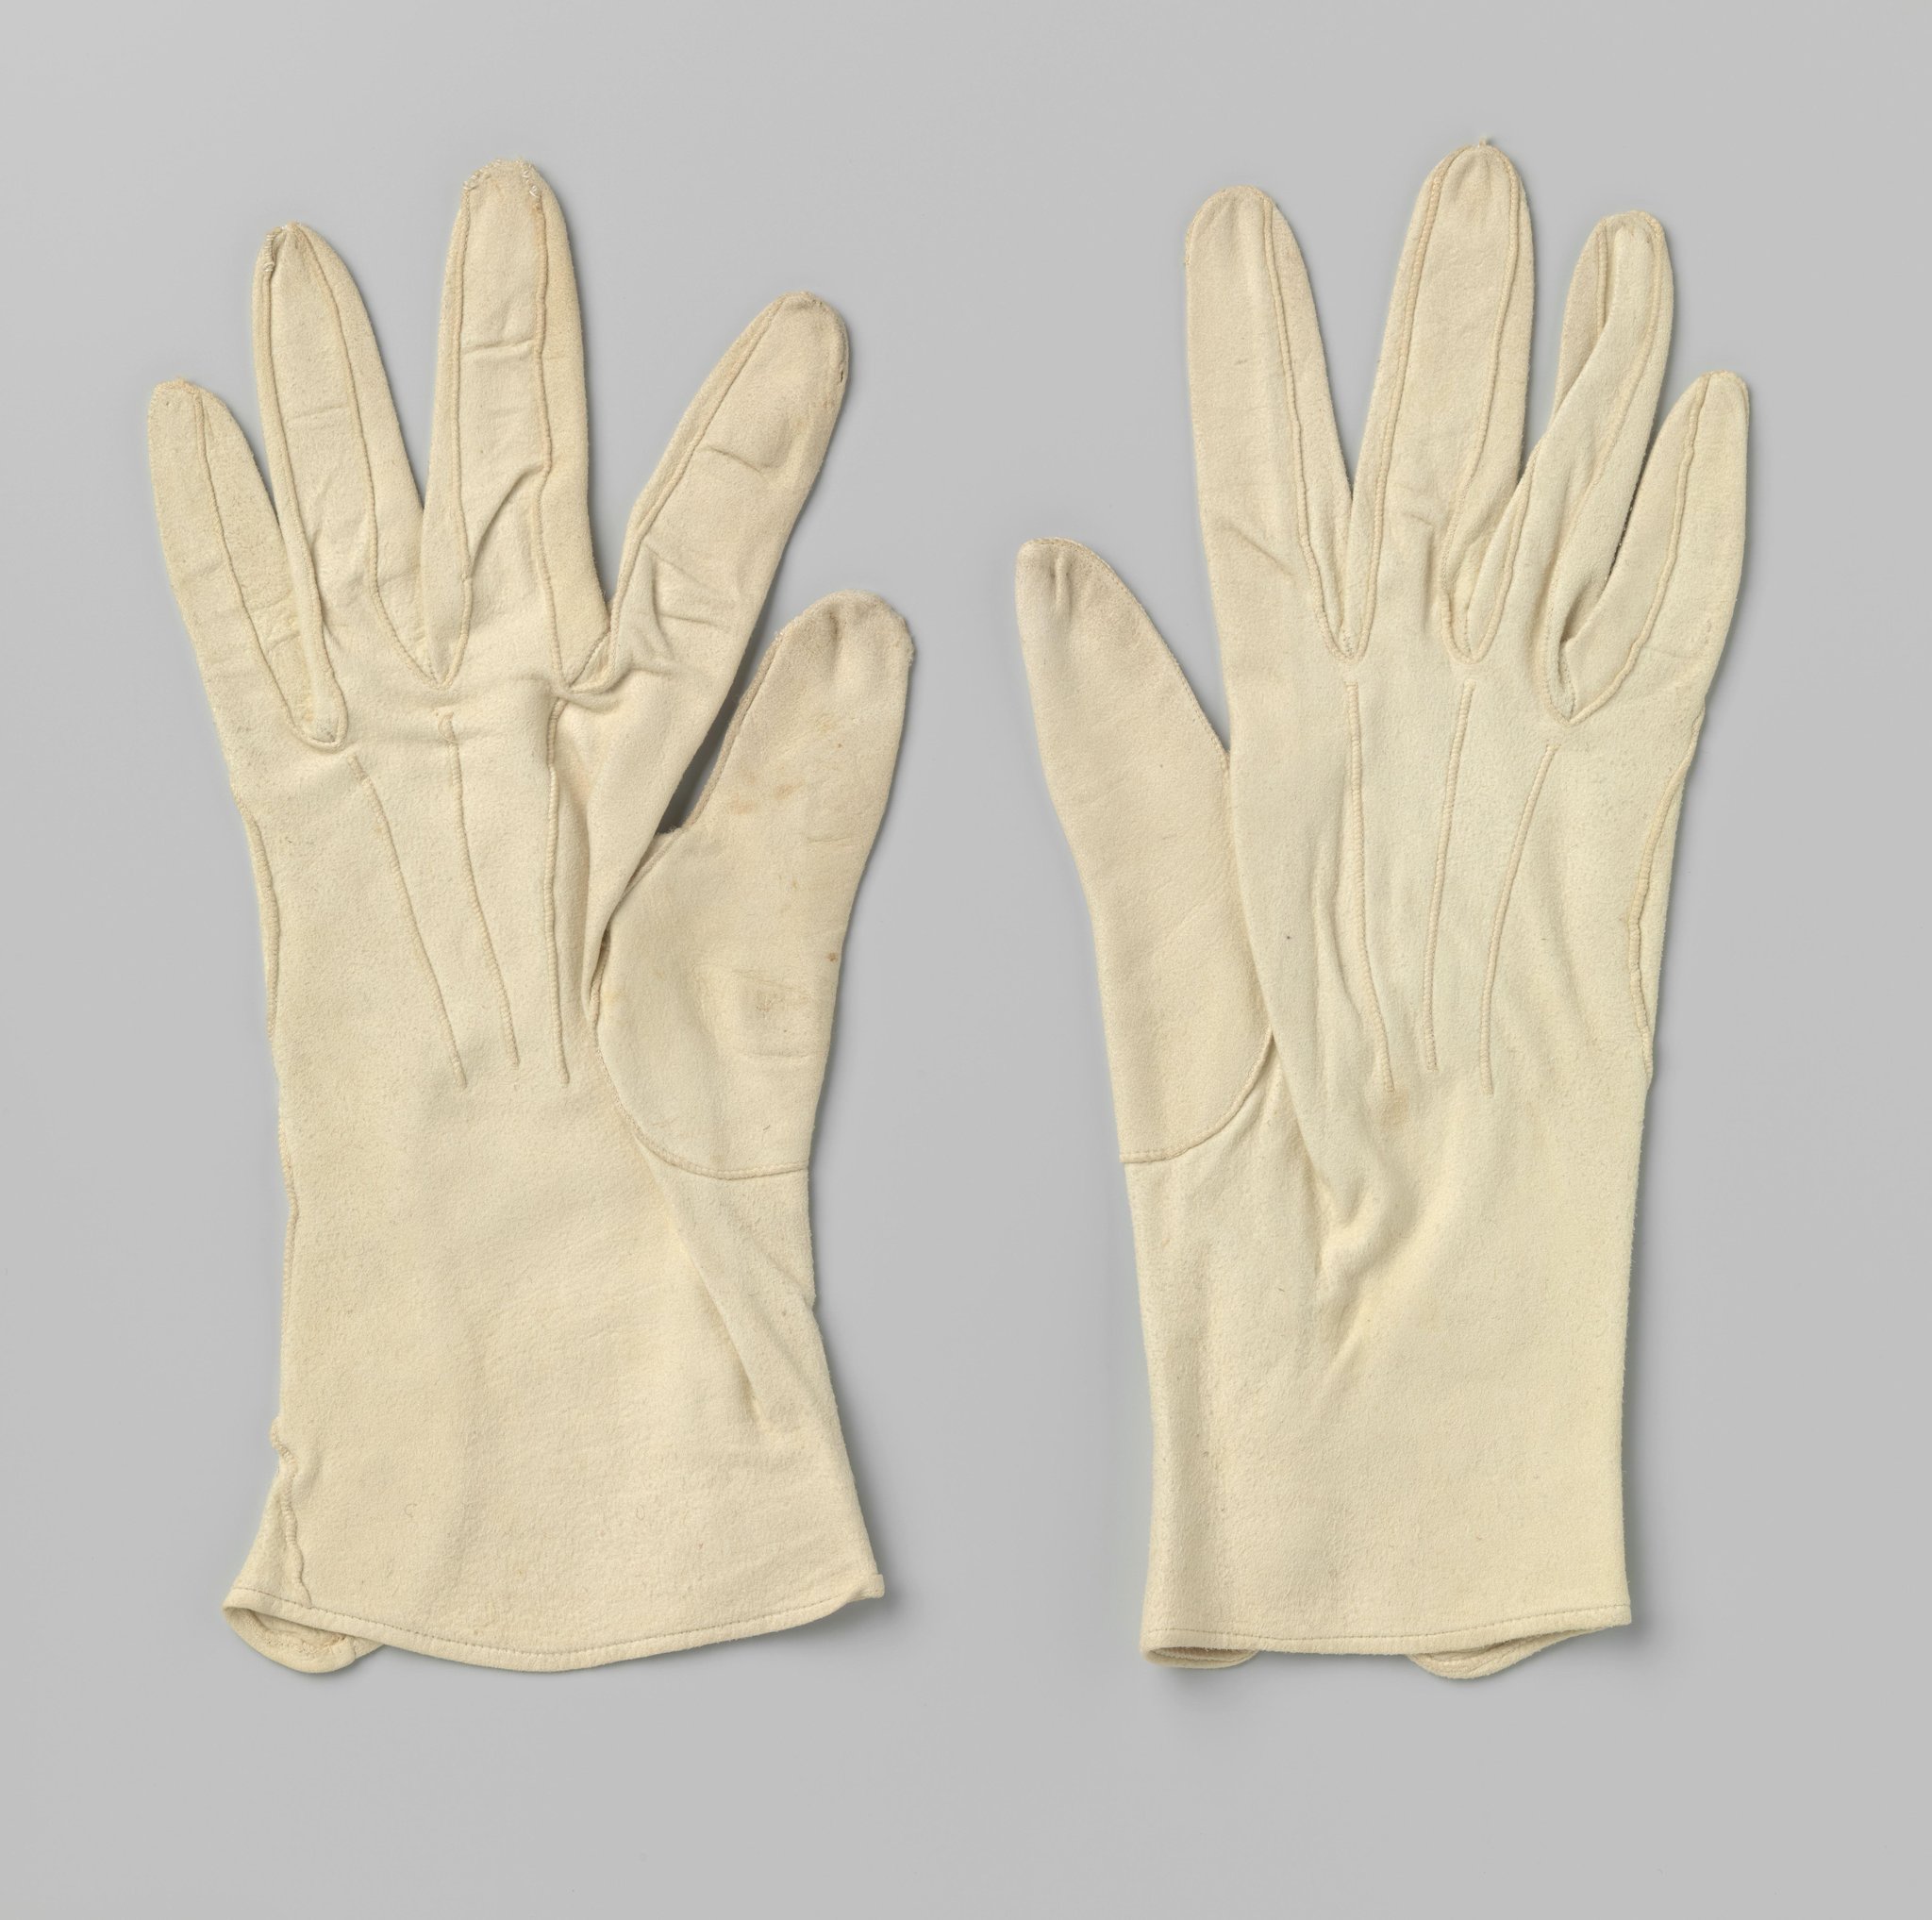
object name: clothing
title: Handschoen van wit zeemleer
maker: Anonymous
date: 1900-1915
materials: leather, plastic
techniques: stitching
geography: western europe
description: Rechterhandschoen van wit zeemleer. Op de rug versierd met drie gestikte verdikte koorden. Aan binnenzijde pols voorzien van drie parelmoerkleurige knopen.